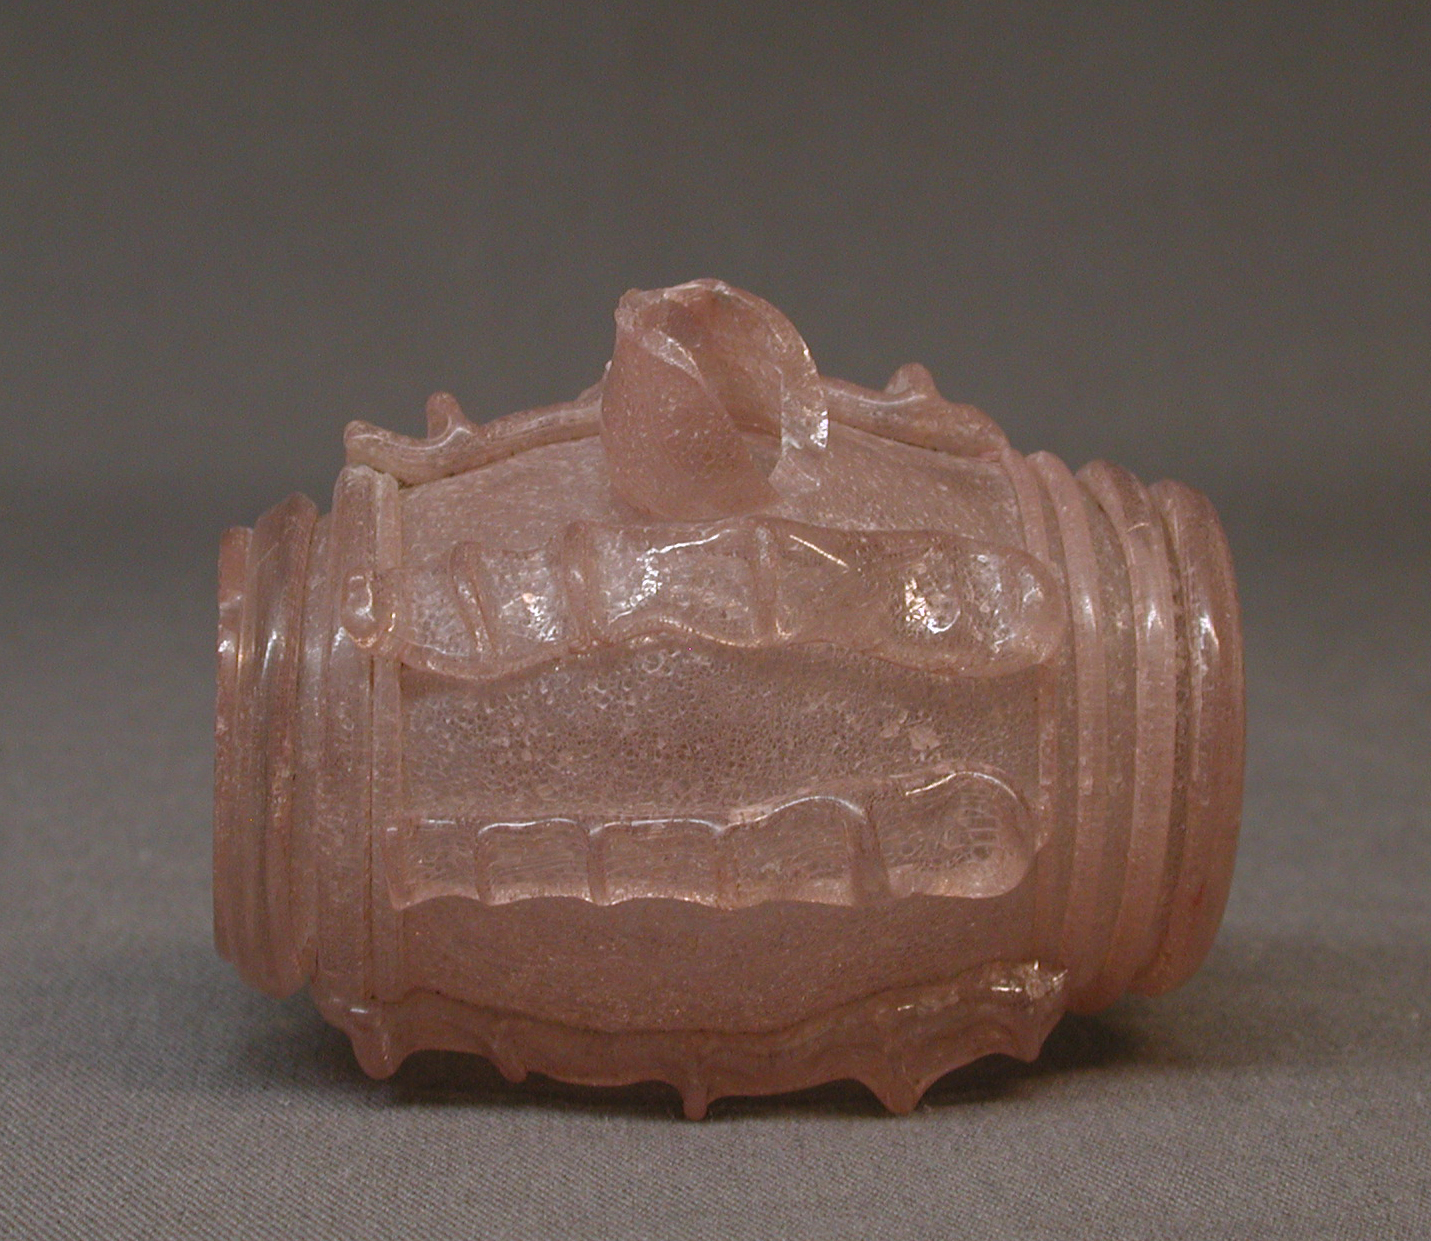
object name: flask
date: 1601-1700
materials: glass